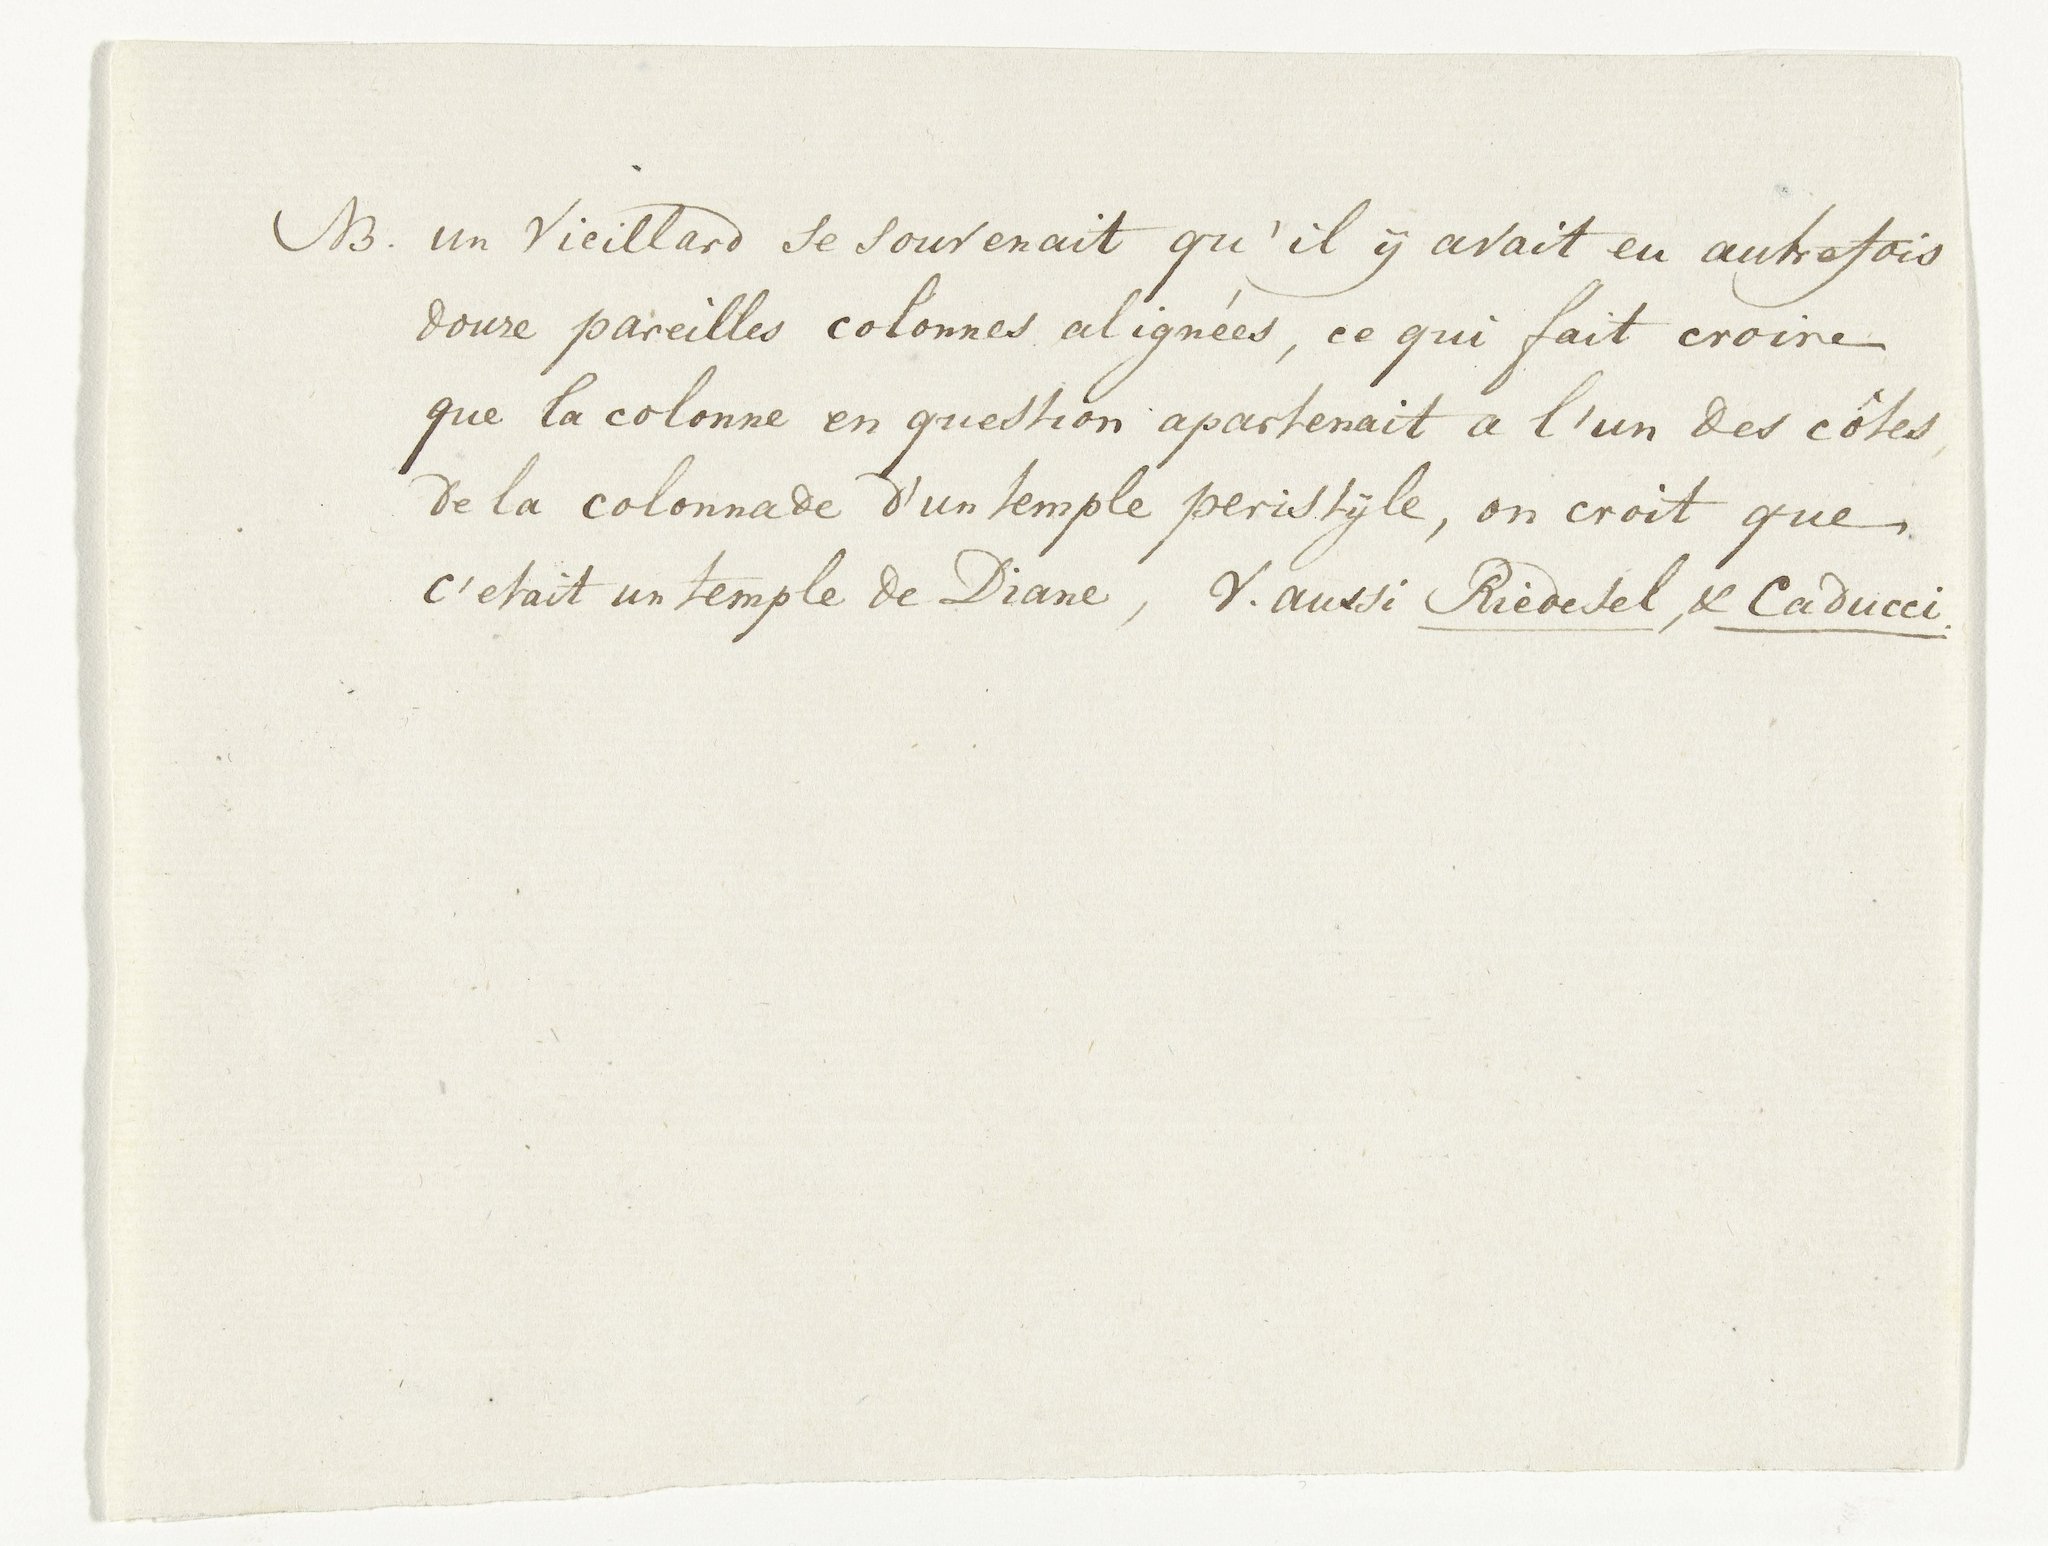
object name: drawing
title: Voyage en Italie, en Sicile et à Malte - 1778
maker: louis ducros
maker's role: draughtsman, print maker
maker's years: 1748-1810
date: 1778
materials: paper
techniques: brush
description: Tekening uit het album 'Voyage en Italie, en Sicile et à Malte', 1778.